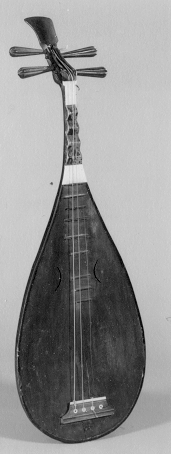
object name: pipa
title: Pipa (琵琶 )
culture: chinese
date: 1801-1900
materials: bamboo, lacquer, mother of pearl, wood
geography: china